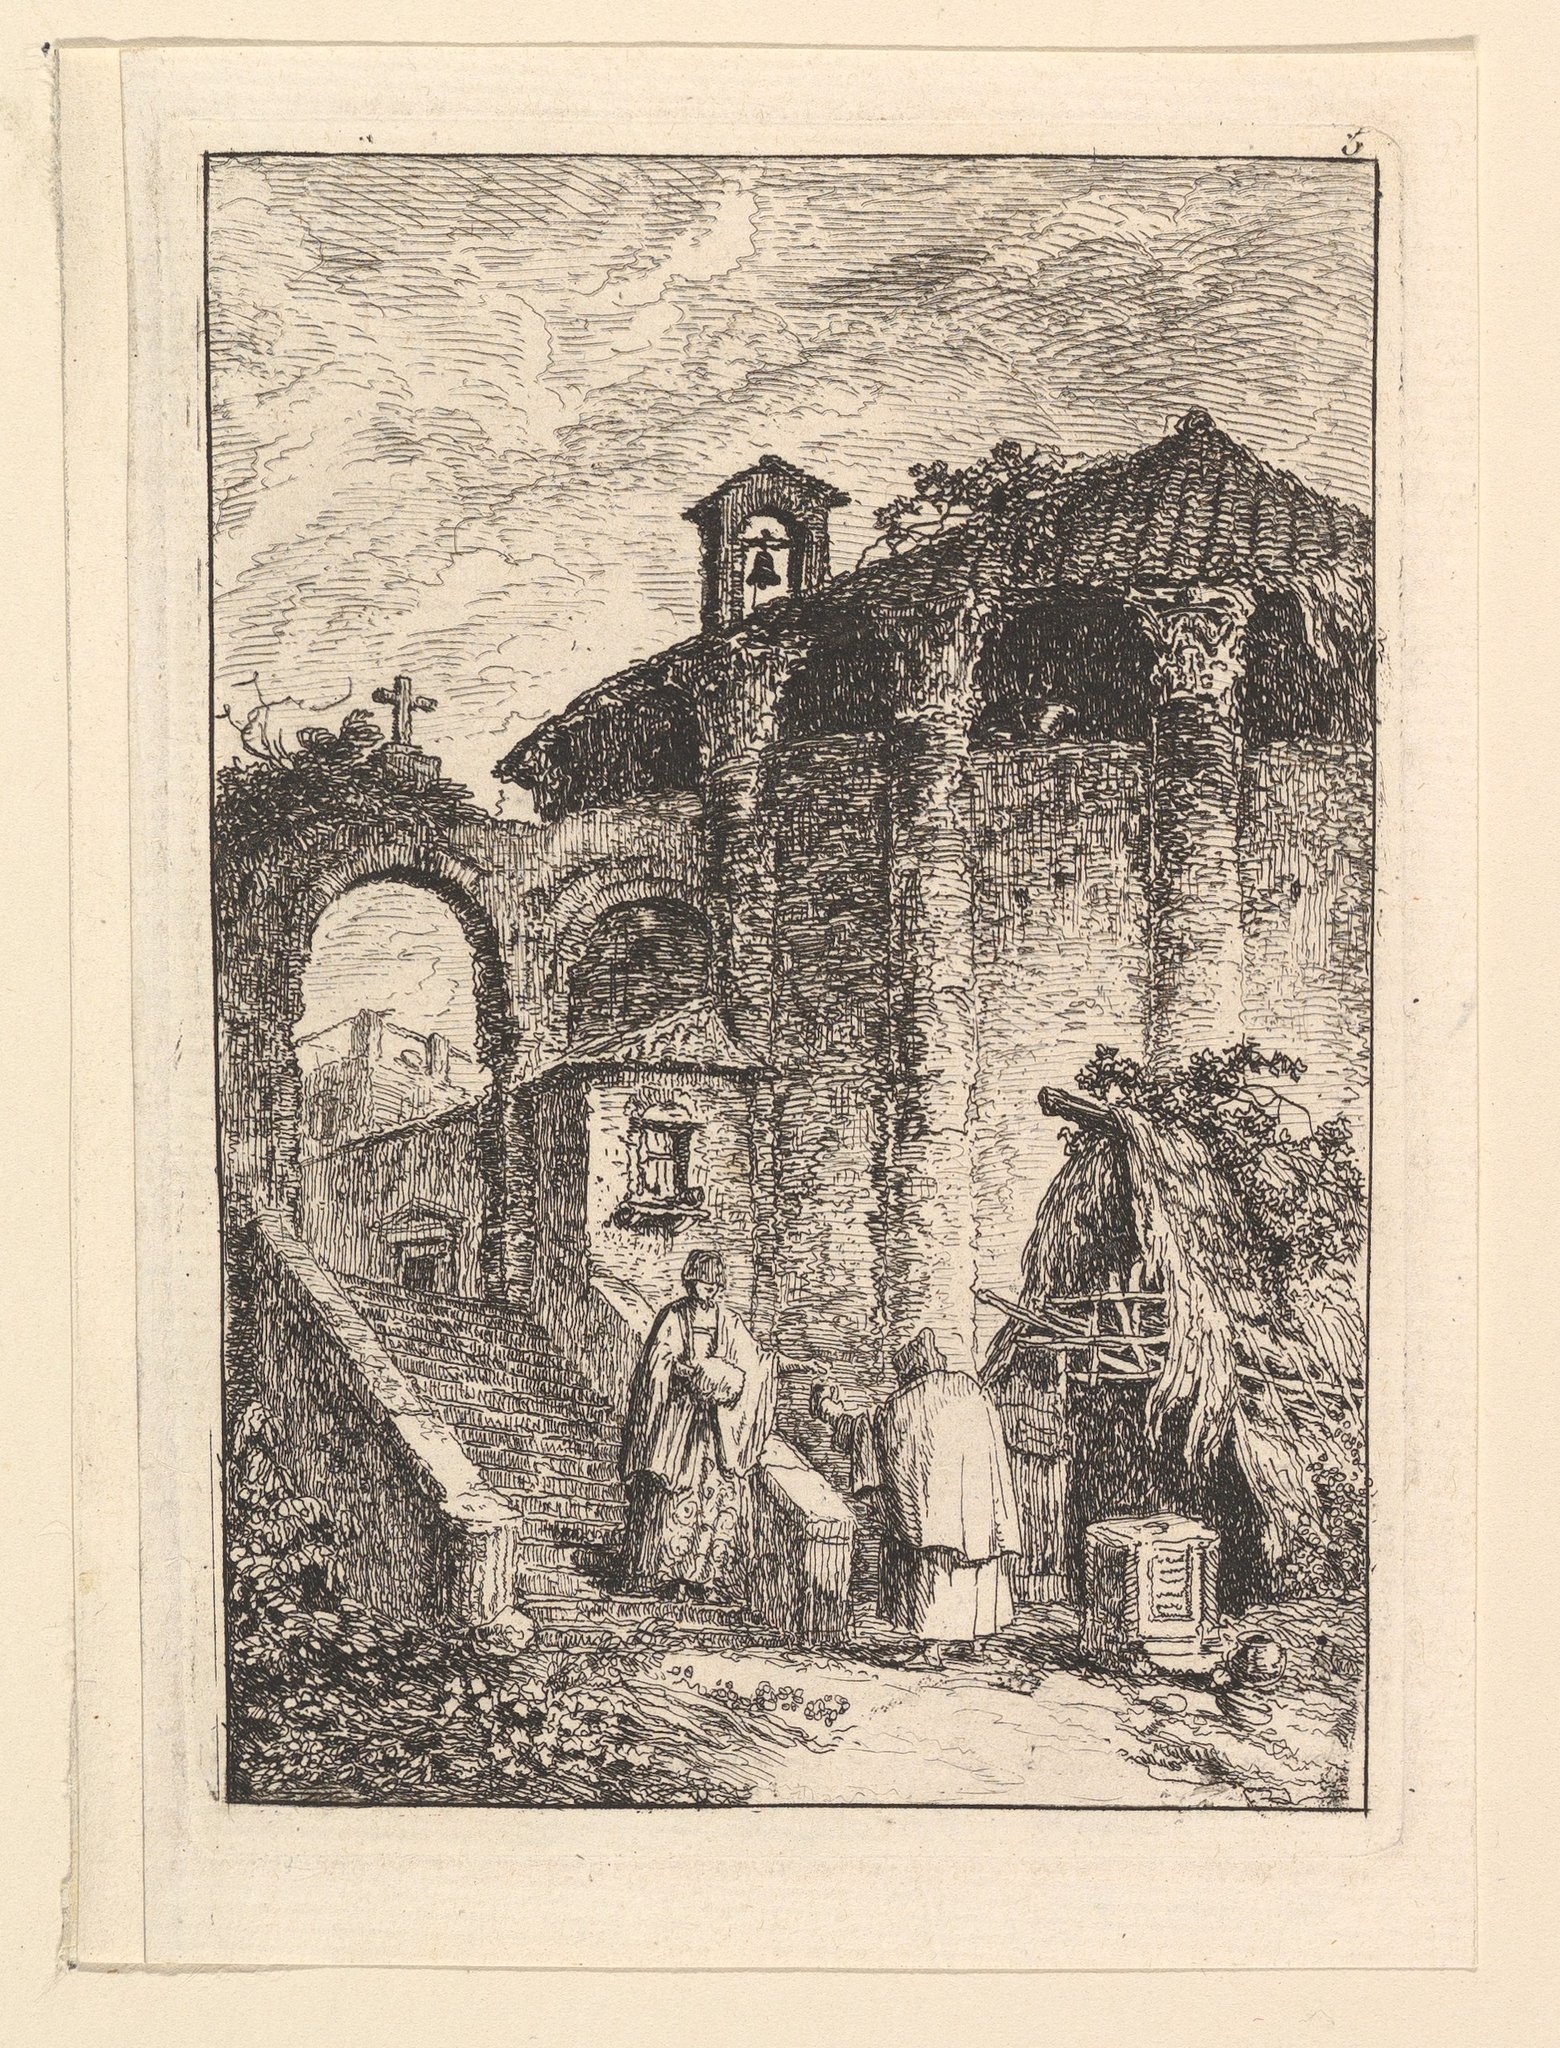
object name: print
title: Le Temple Antique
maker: hubert robert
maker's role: artist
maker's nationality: french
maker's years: 1733-1808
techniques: etching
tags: temples